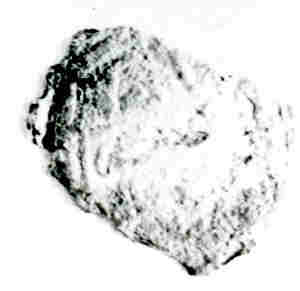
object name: coin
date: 701-900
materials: copper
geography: iran